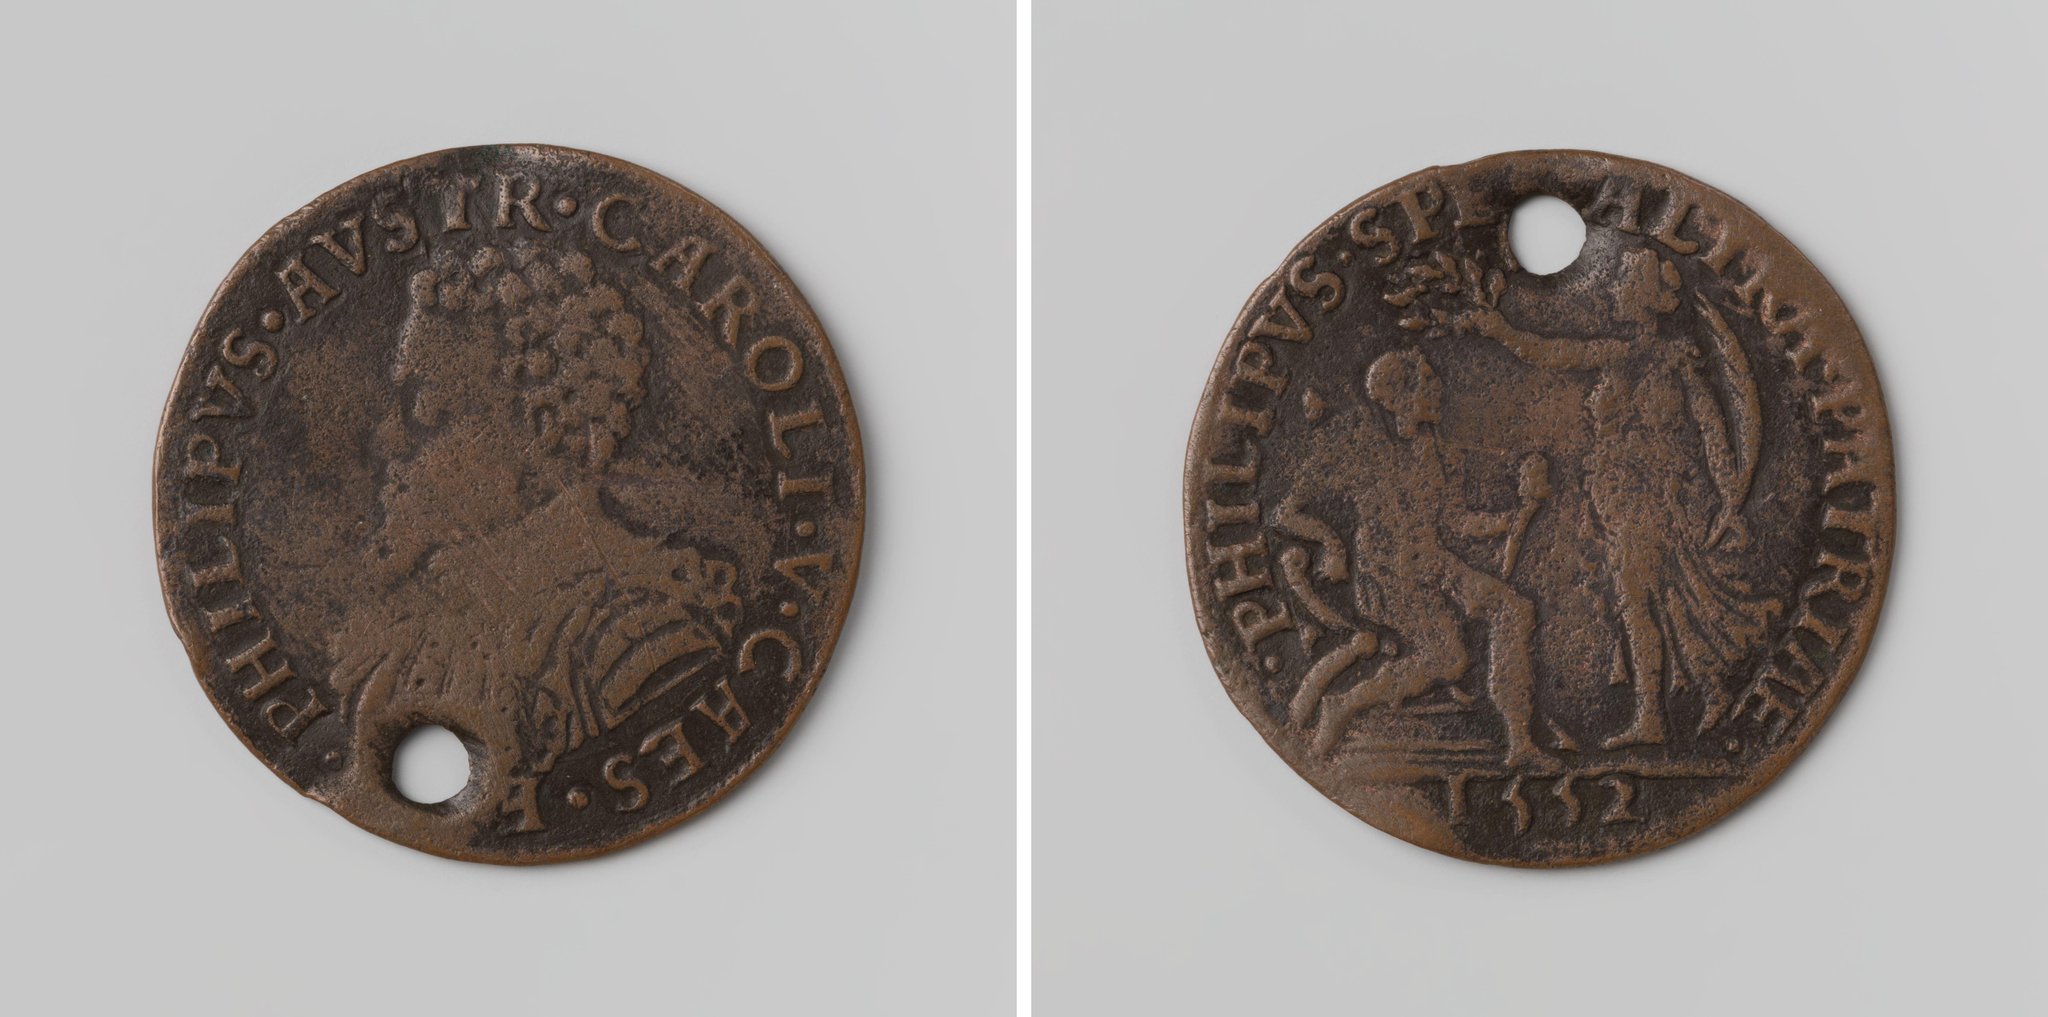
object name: jeton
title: Filips, erfprins van Spanje, opvolger van Karel V als heer der Nederlanden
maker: Anonymous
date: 1552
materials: copper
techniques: striking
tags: philip ii of spain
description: Koperen penning met gat erin. Voorzijde: borststuk man binnen omschrift. Keerzijde: staande vrouw, voorstellende Overwinning, houdt palmtak in linkerhand en houdt met uitgestrekte rechterhand een lauwerkrans boven hoofd van Filips, die in Romeins tenue gekleed, op stoel zit met commandostaf in hand binnen omschrift; afsnede: jaartal